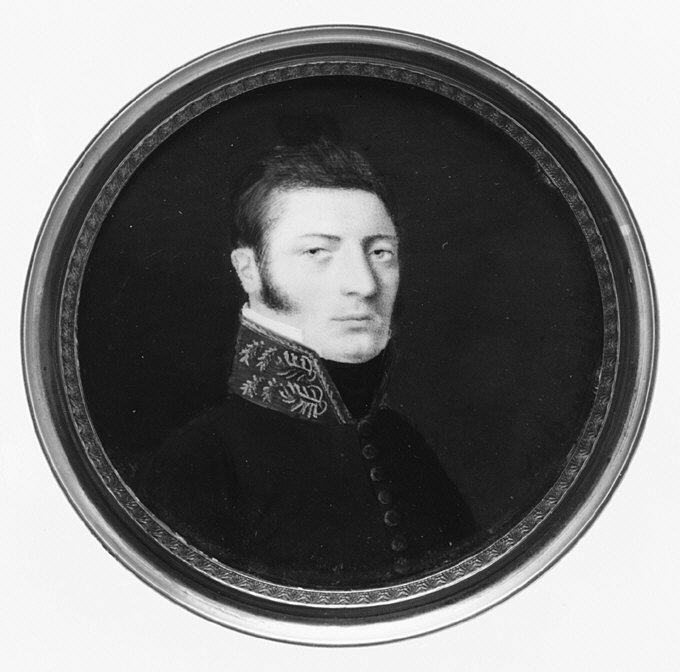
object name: painting, miniature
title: François Joseph Lefebvre (1755–1820)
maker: french painter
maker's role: artist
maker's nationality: french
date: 1800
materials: ivory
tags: men,portraits